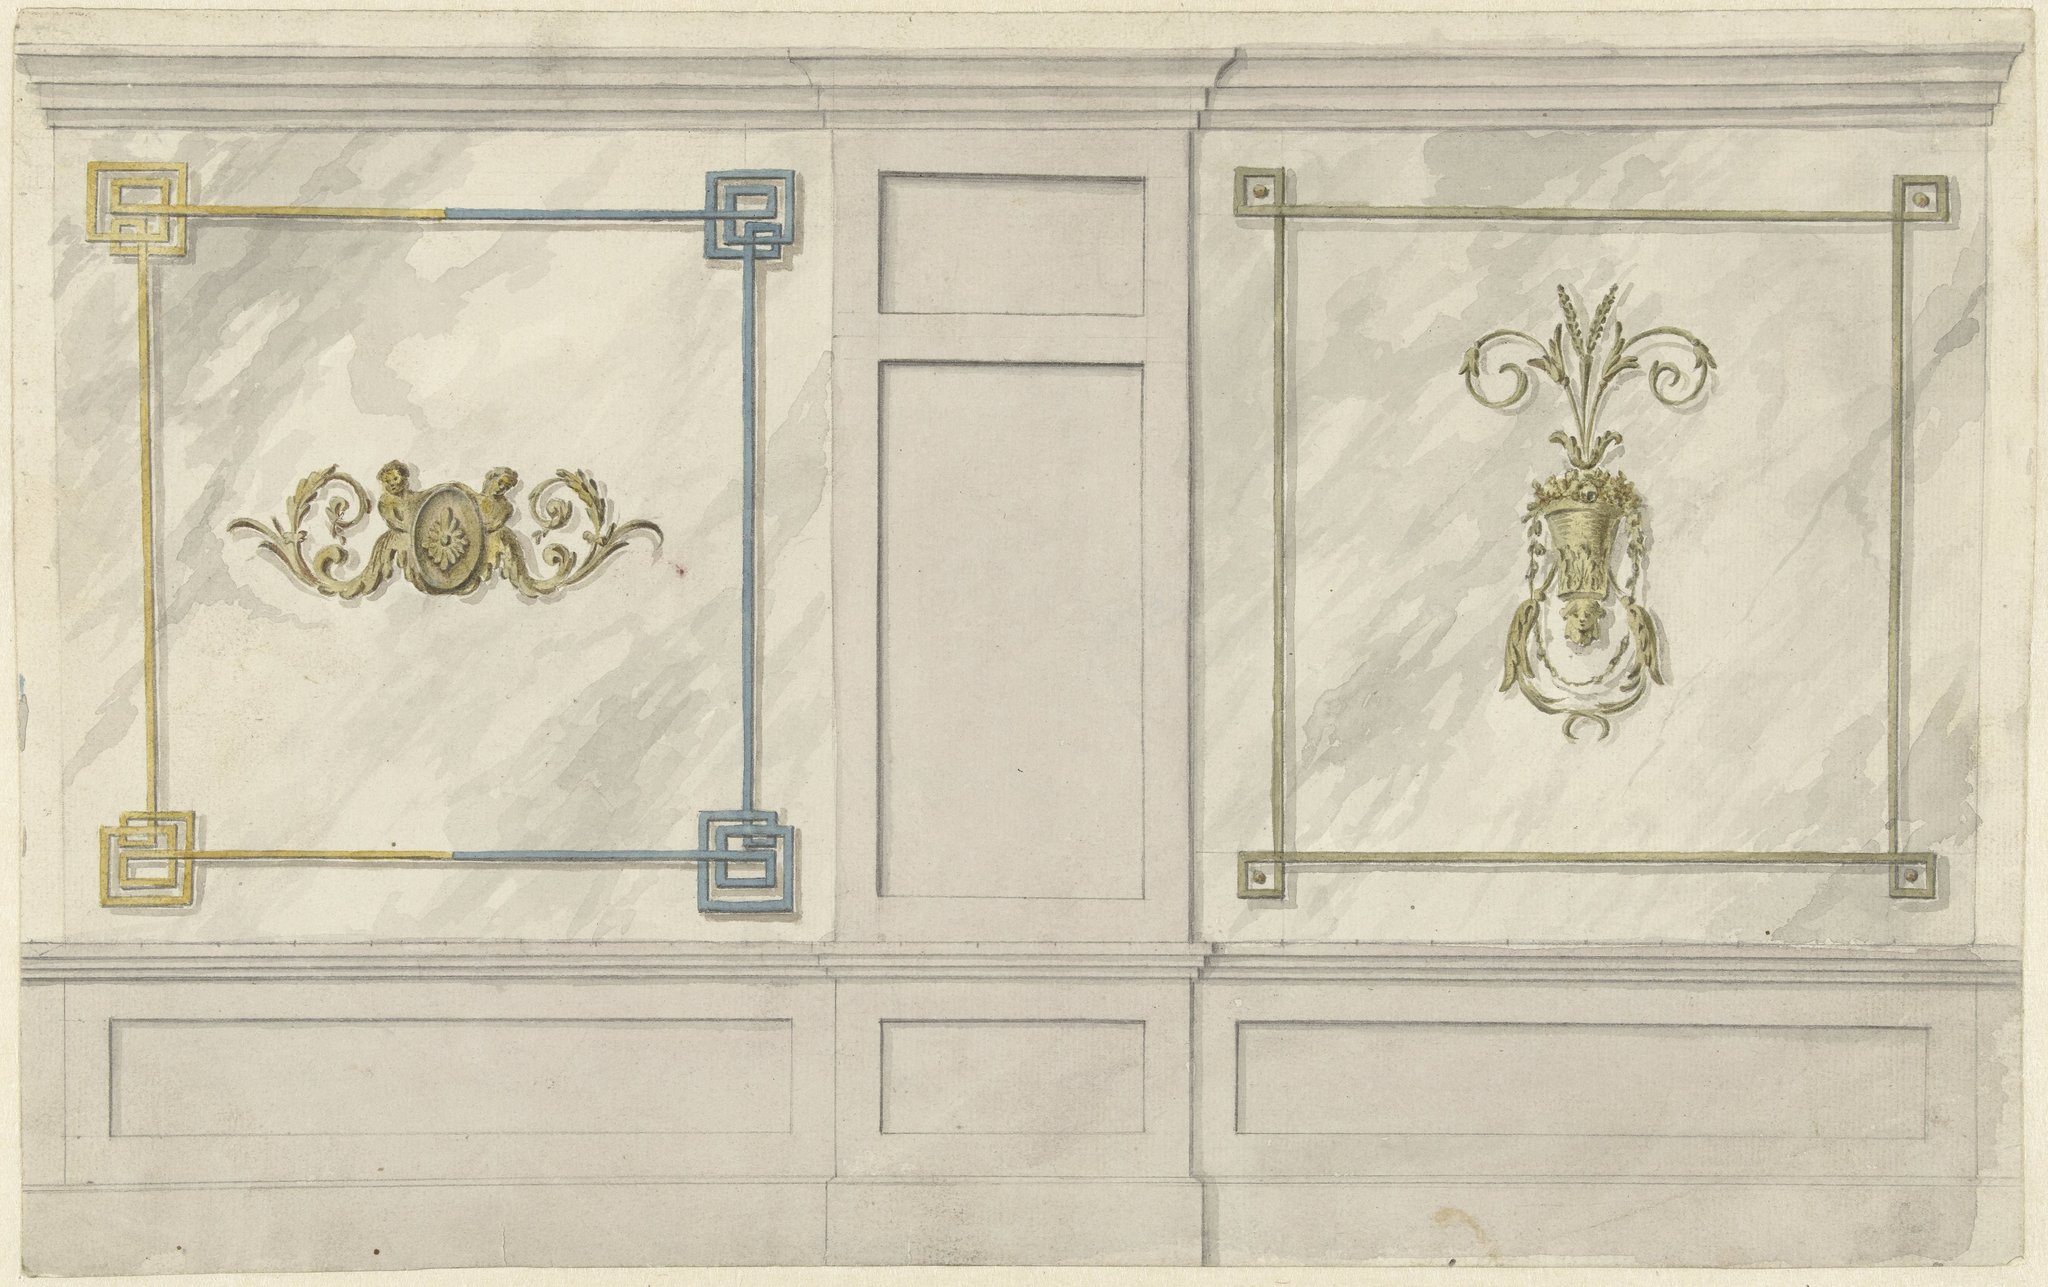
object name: design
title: Ontwerp voor kamerversiering met twee panelen met ornamenten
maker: abraham meertens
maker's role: draughtsman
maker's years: 1757-1823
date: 1767-1823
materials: ink, paper, pencil, watercolor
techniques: brush, pen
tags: wall-covering